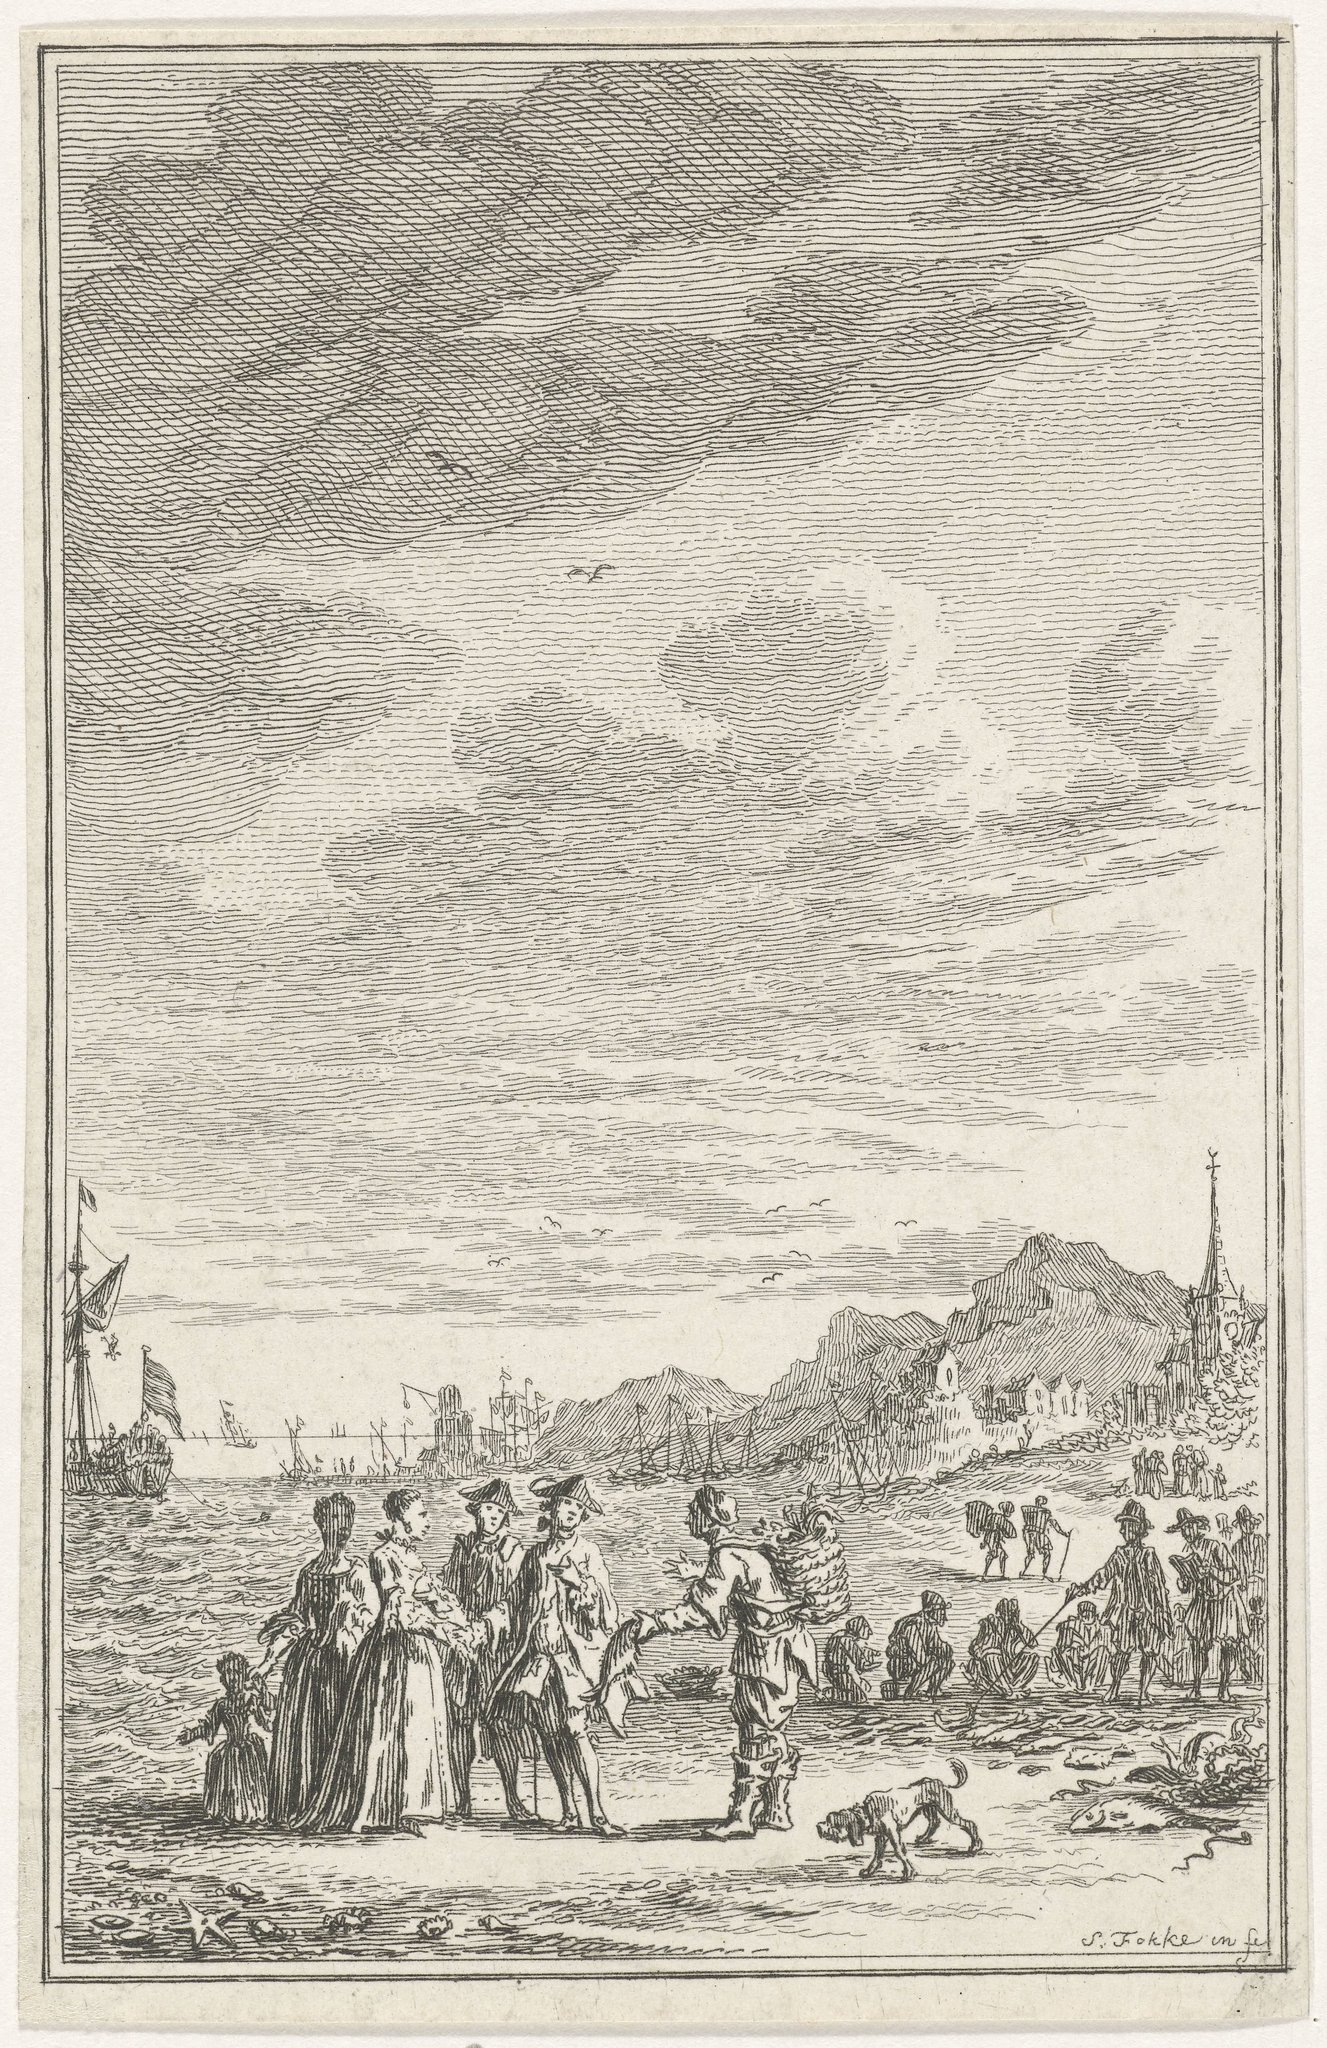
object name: print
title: Visverkoop op het strand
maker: simon fokke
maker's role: draughtsman, print maker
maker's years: 1712-1784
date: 1722-1784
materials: paper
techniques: etching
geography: amsterdam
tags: fisherman showing catch, beach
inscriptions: collector's mark: Lugt 2228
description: Op het strand spreekt een man met een mand op zijn rug en een vis in zijn hand een gezelschap aan bestaande uit twee echtparen en een meisje. Verderop staan meer vissers en figuren die de op het strand uitgestalde vis bekijken.